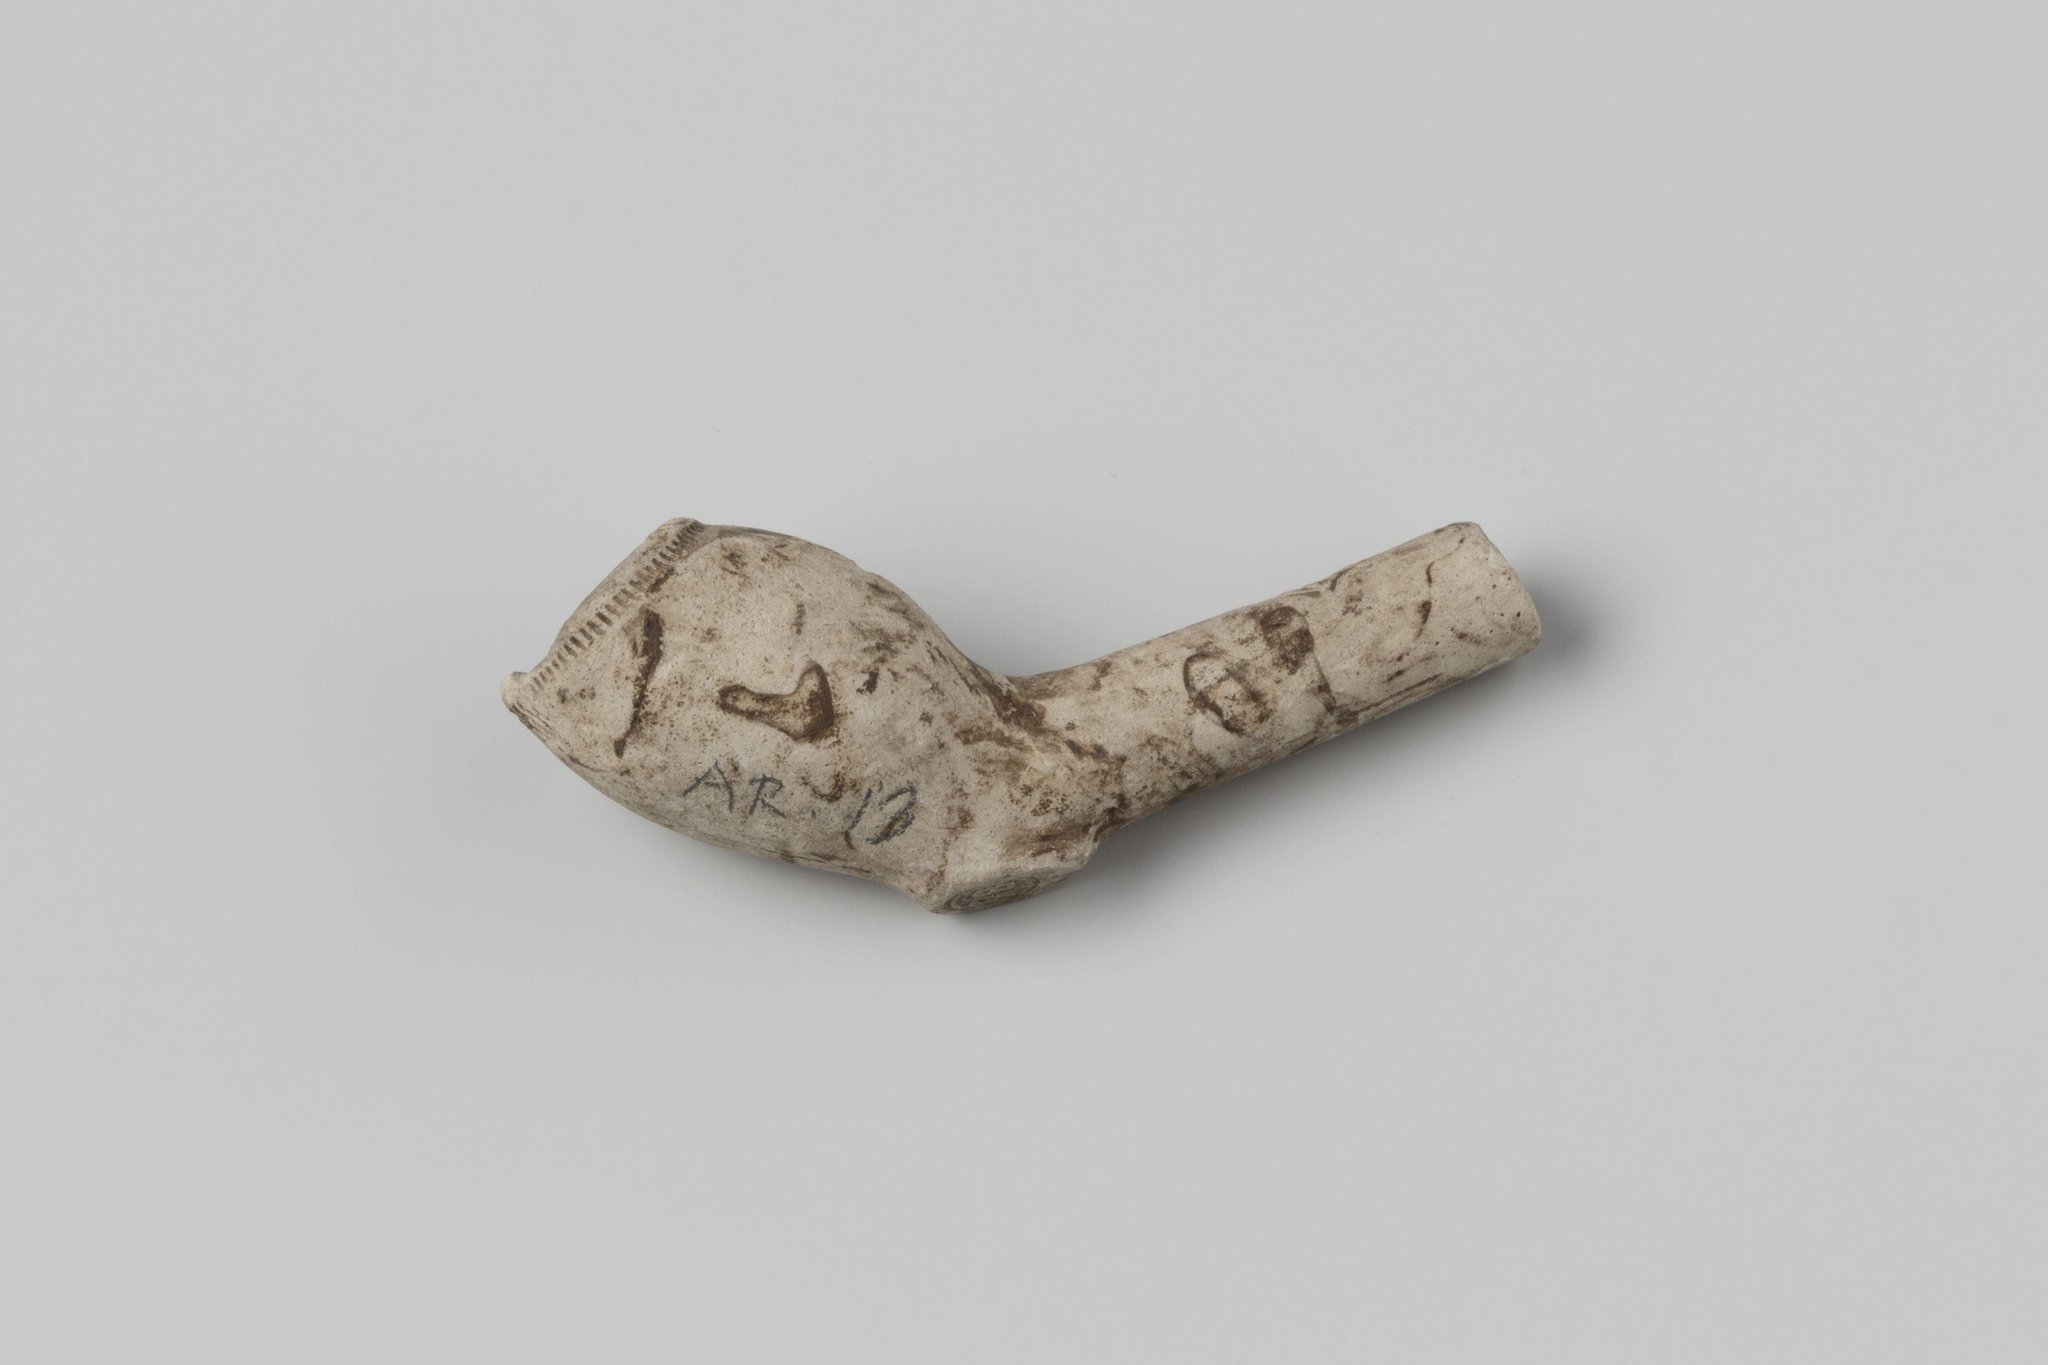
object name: fragment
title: Fragment tabakspijp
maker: Anonymous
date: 1630-1645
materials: clay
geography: netherlands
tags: directeur, hoogleraar, caspar jacob christiaan reuvens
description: Fragment tabakspijp. Van de opgravingen op de Hofstede Arentsburg 1827-1831 onder toezicht van Professor Reuvens.